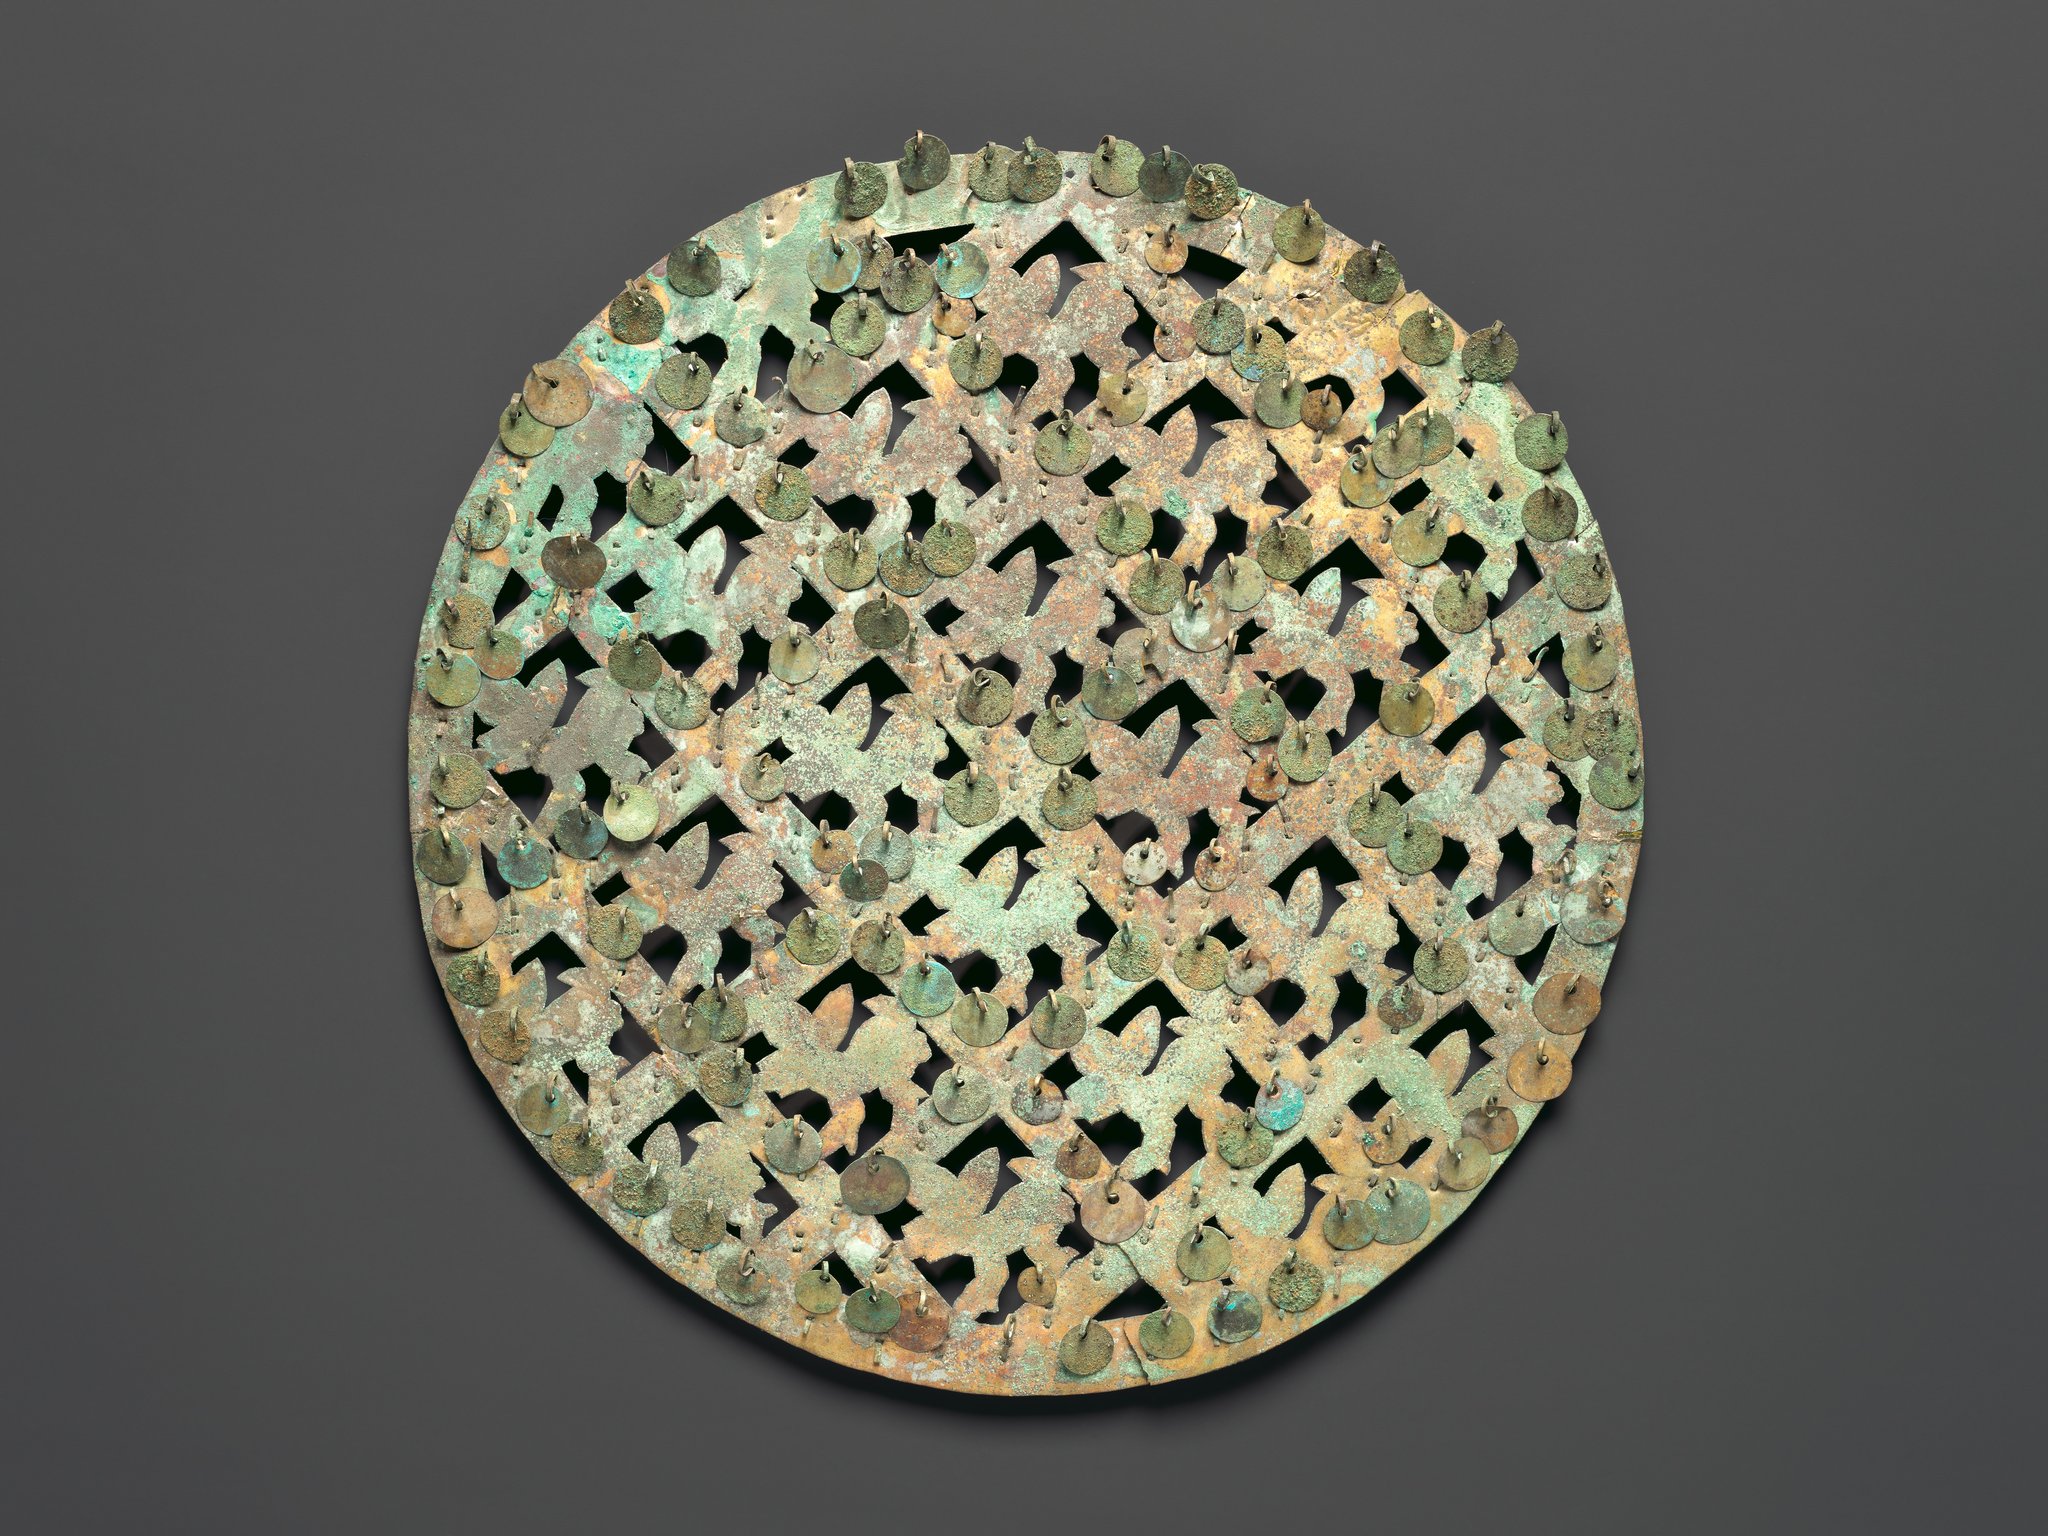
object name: ornament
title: Disk Ornament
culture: moche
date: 501-700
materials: gilt copper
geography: peru